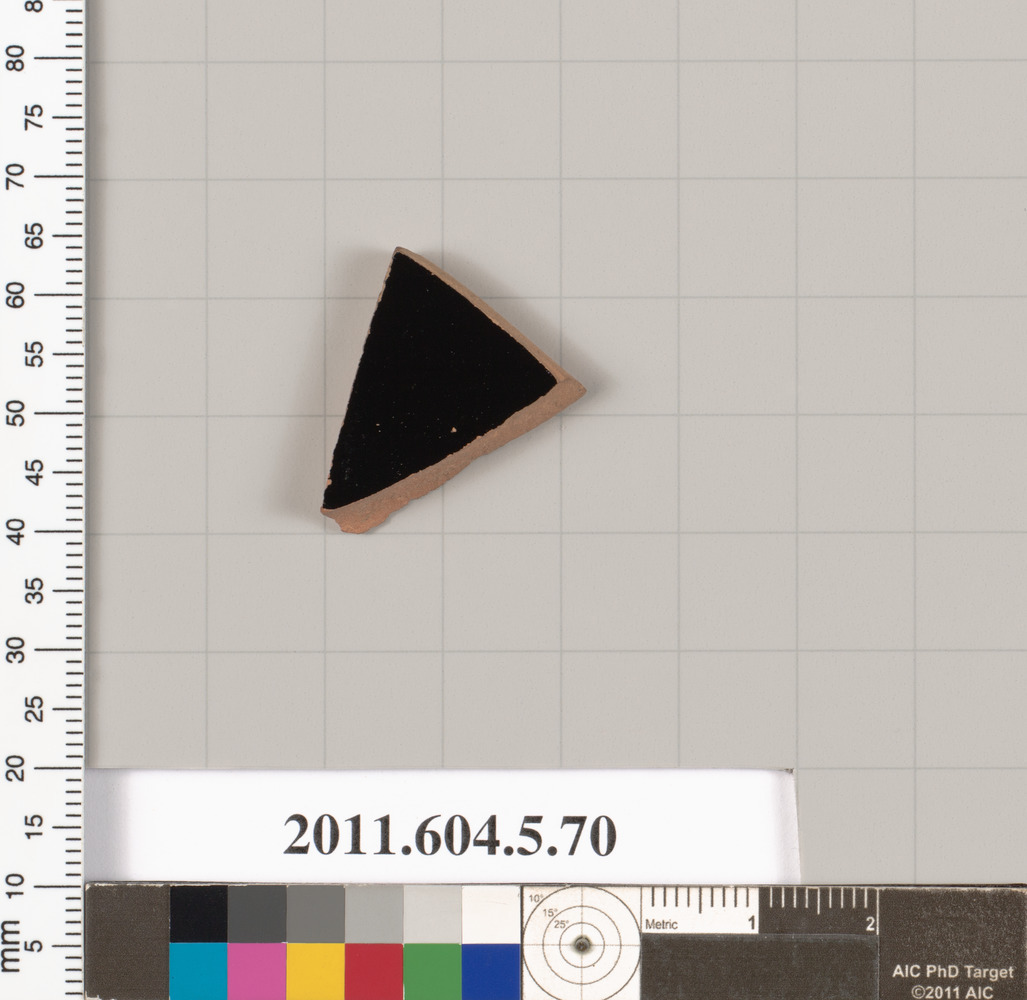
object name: kylix fragment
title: Terracotta fragment of a kylix (drinking cup)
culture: greek, attic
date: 500-480 BCE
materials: terracotta